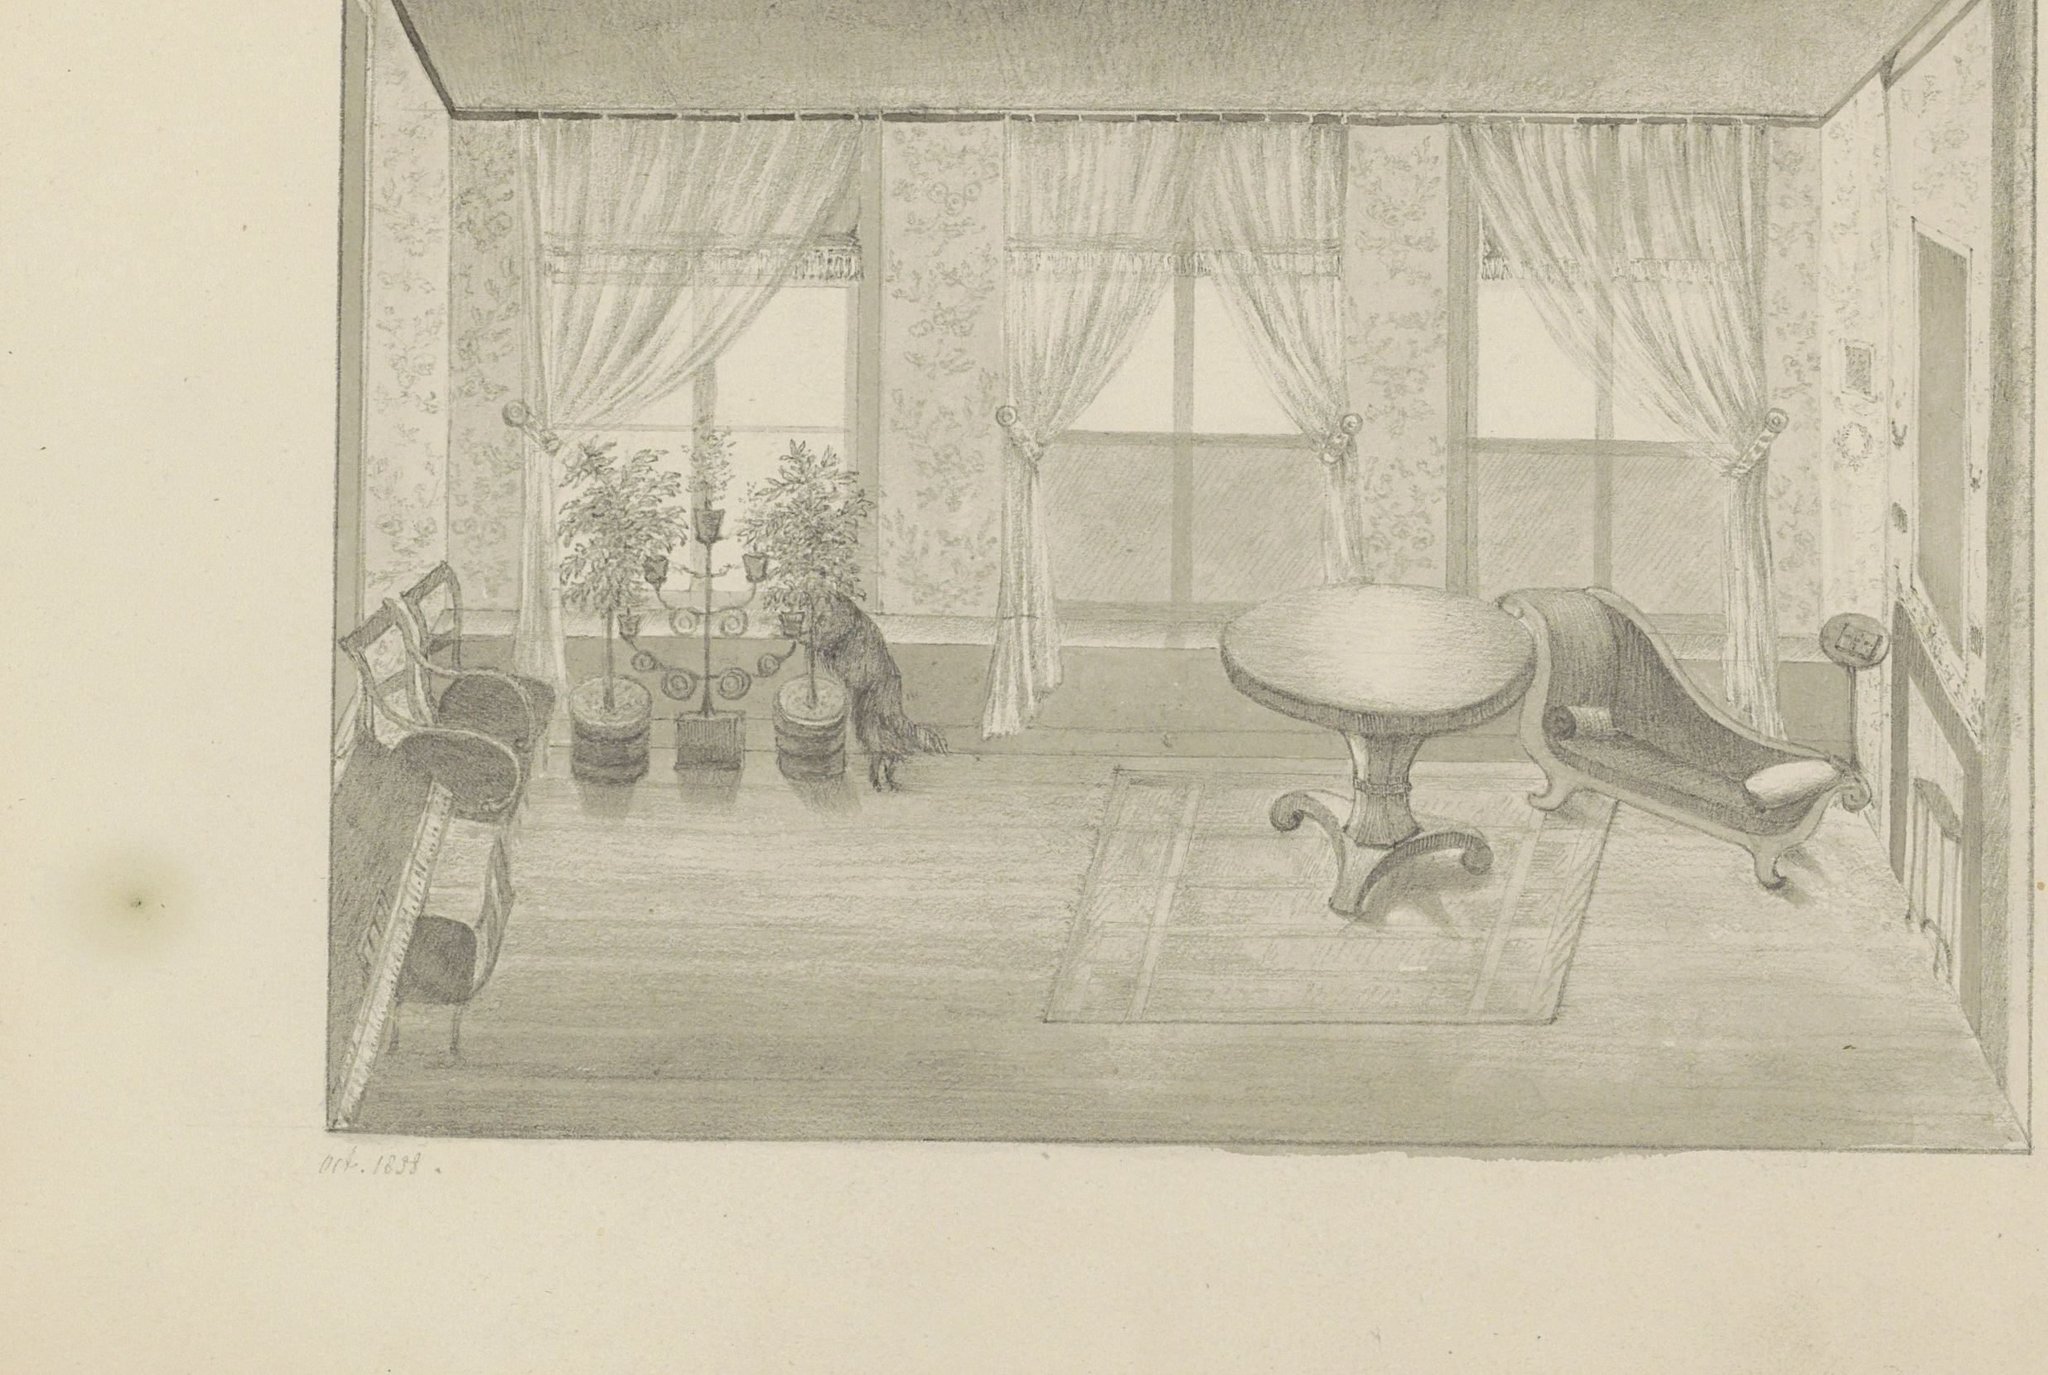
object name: sketchbook leaf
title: Interieur van een salon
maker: Anonymous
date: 1810-1838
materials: paper, pencil, watercolor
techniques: brush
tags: drawing-room, 'salon'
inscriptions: date: ‘oct. 1838.’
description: Interieur van een salon met drie vensters, planten, een bloemstandaard, tafel en chaise longue. Tekening in een kader. Blad 4 recto uit een schetsboek met 45 bladen.